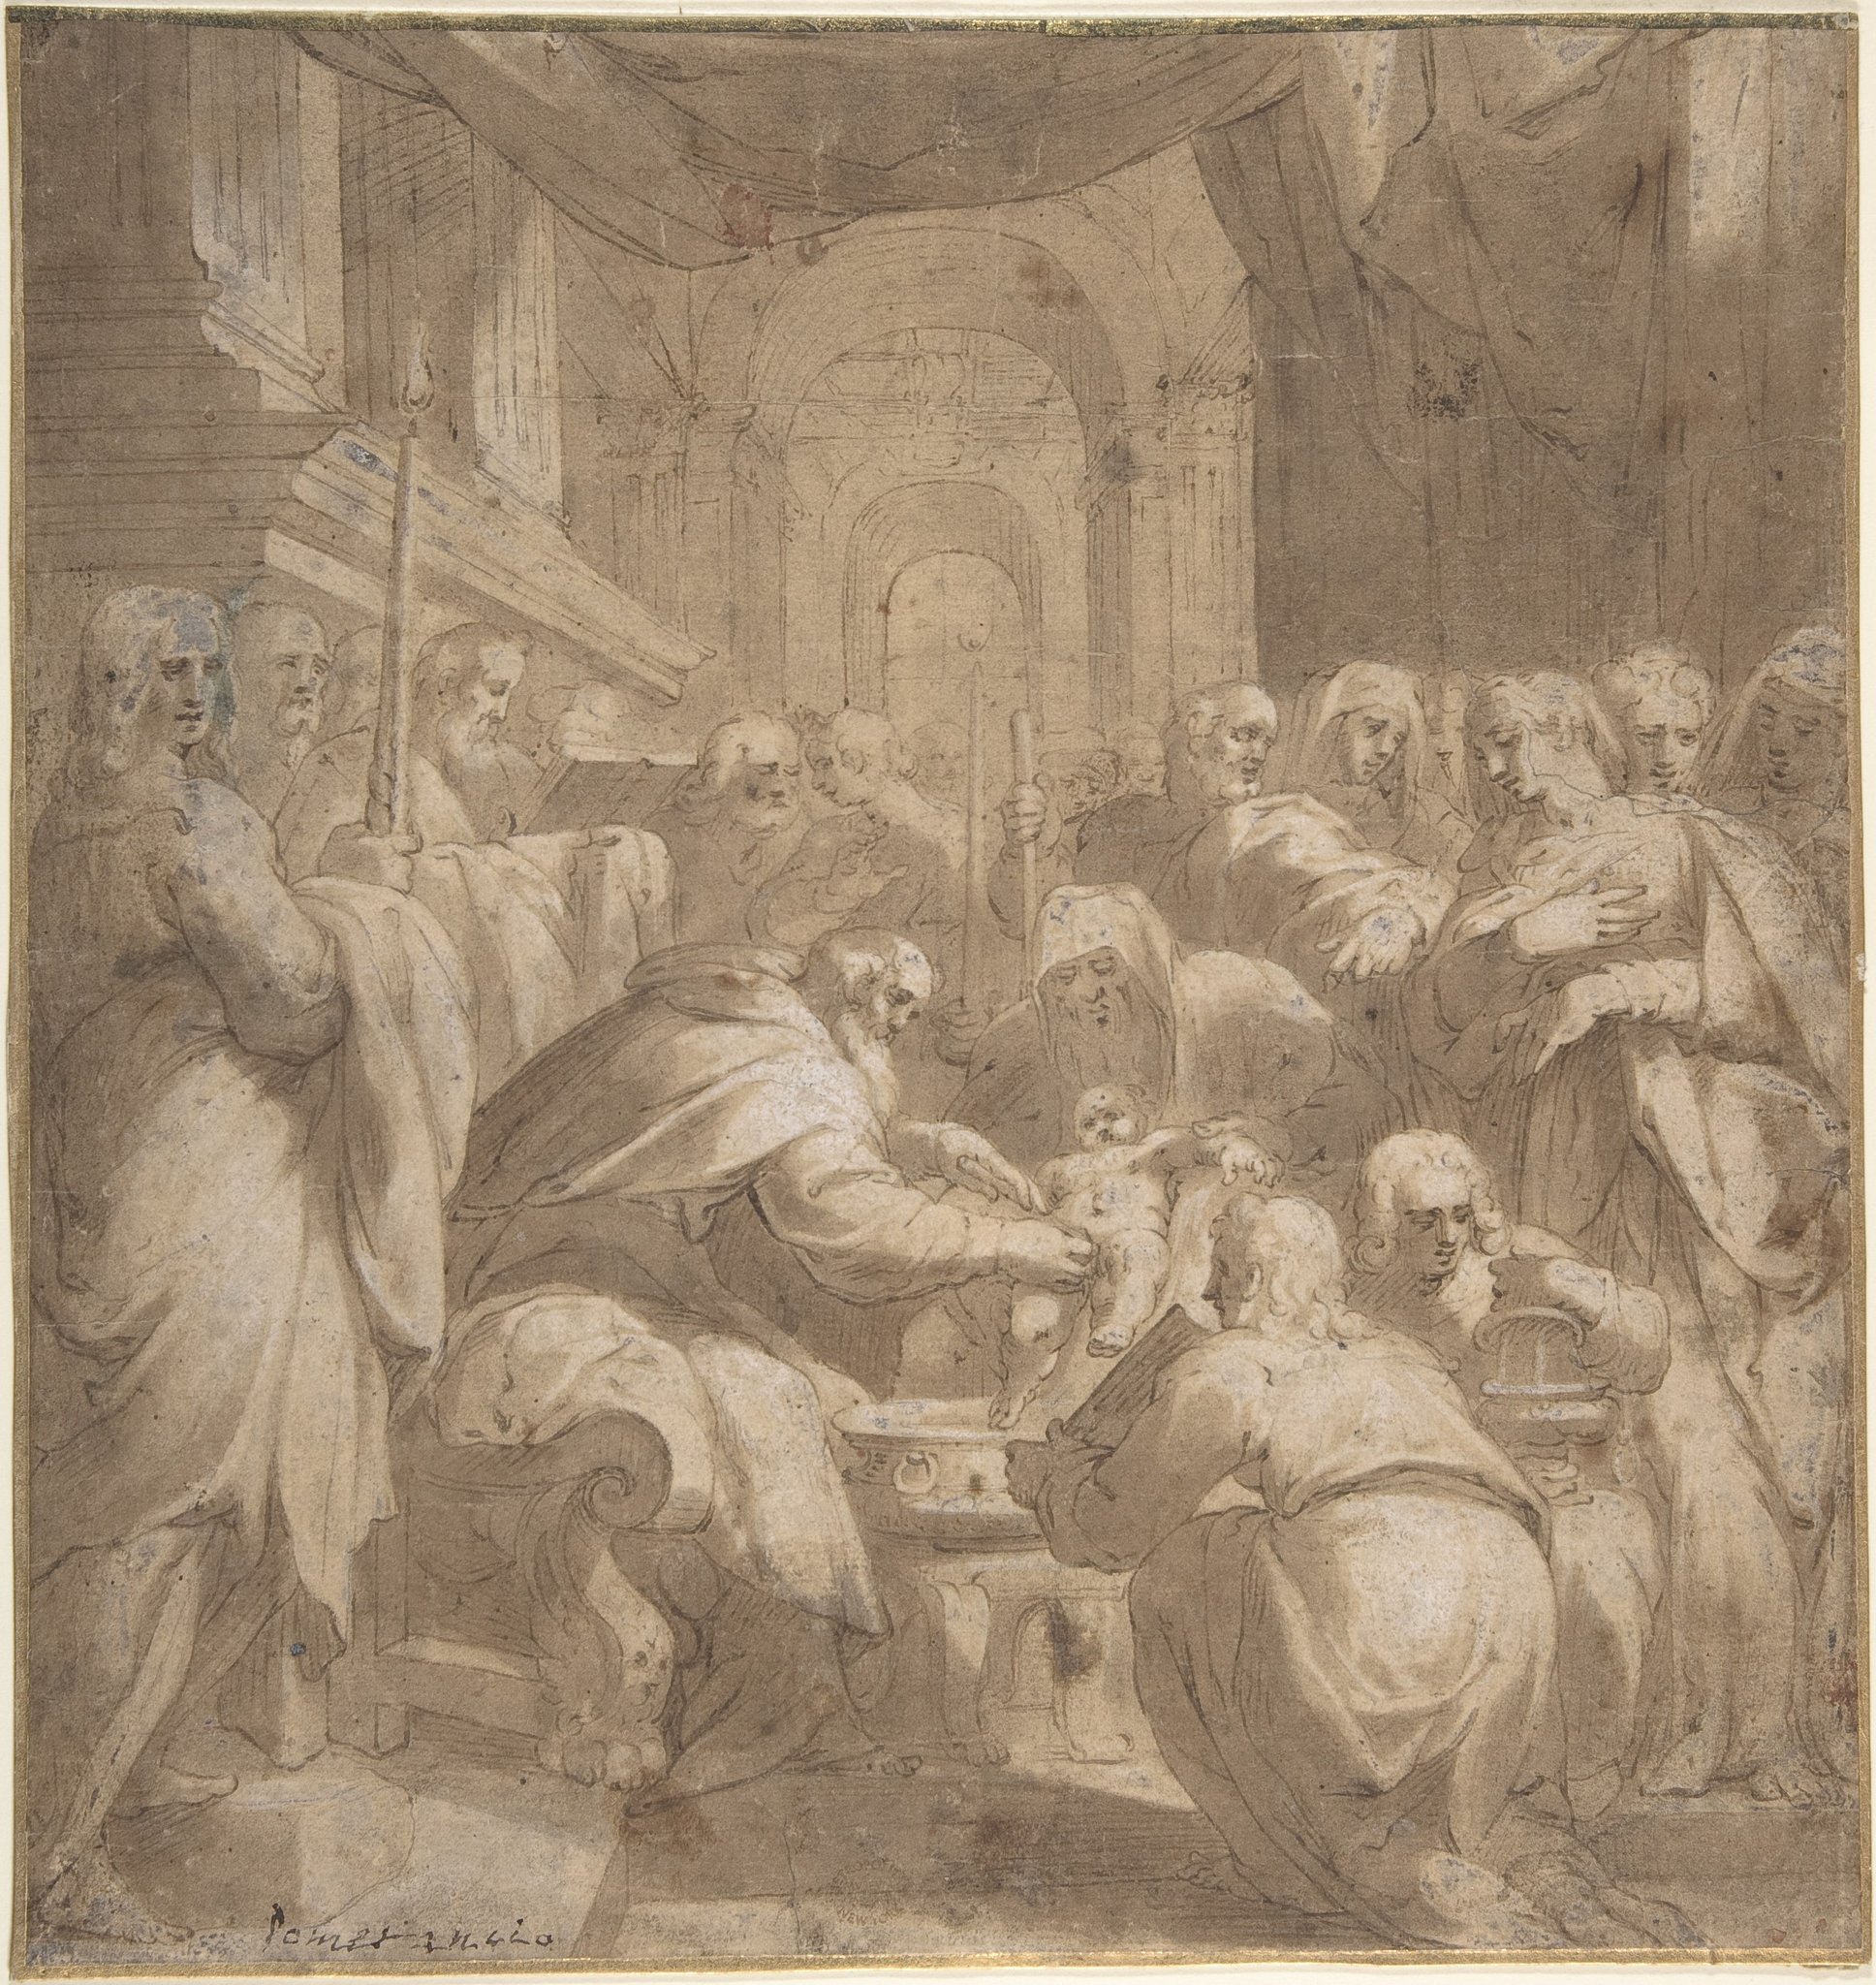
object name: drawing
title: Circumcision in the Temple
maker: hans speckaert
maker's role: artist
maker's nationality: netherlandish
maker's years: -1577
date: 1577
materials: chalk, ink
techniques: brush, heightening, pen, wash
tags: men,jesus,circumcision